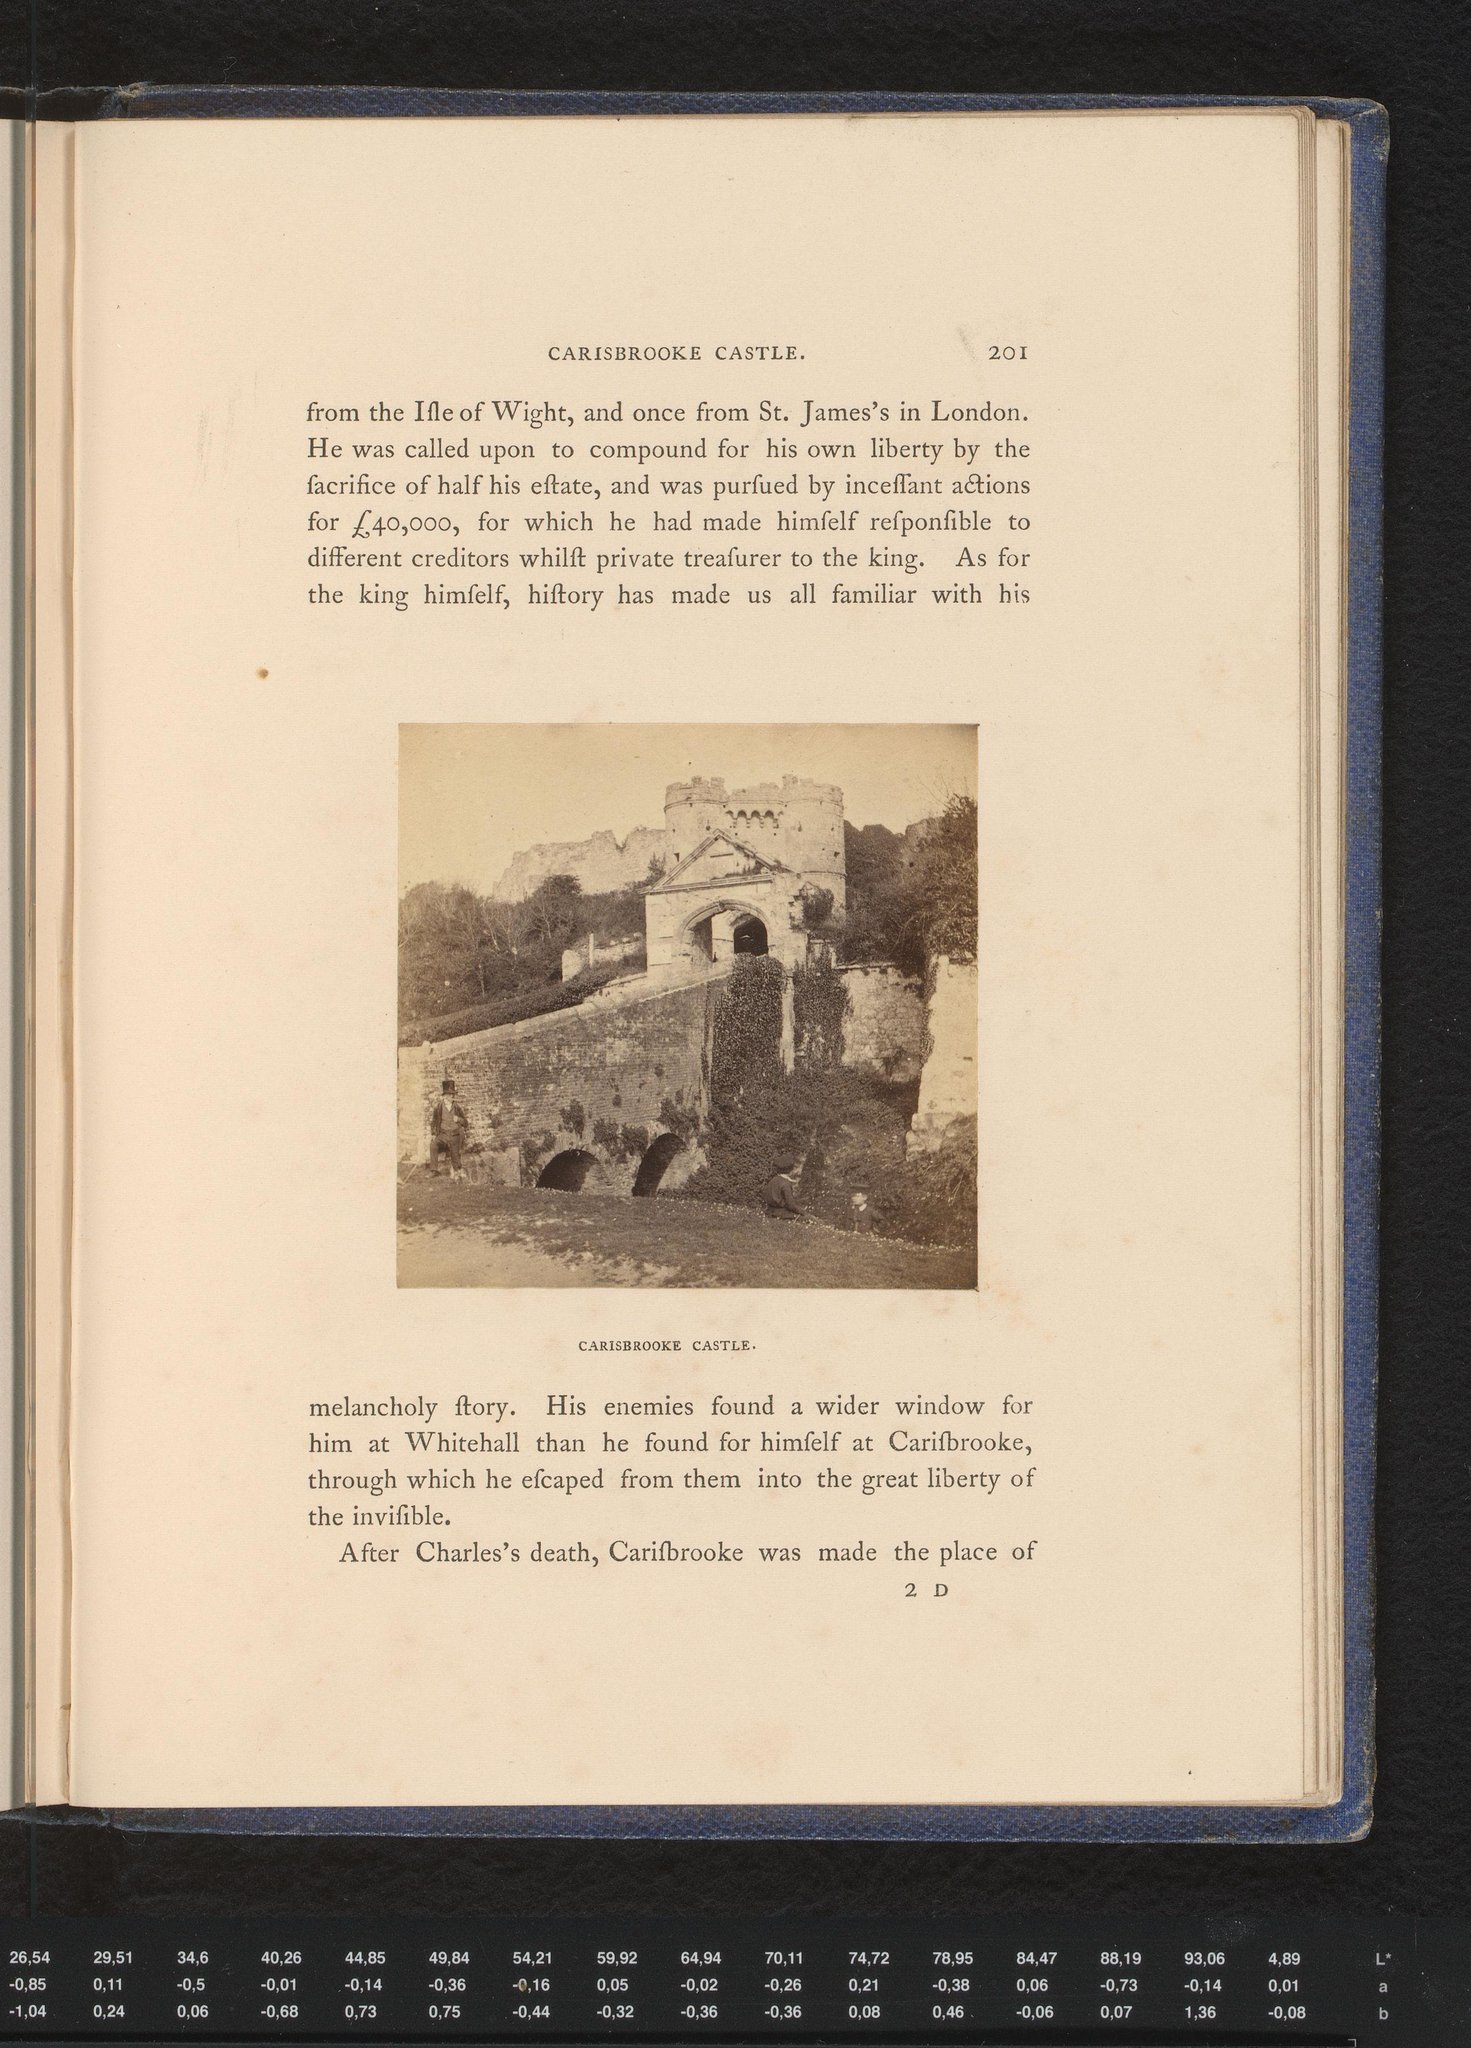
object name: page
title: Gezicht op Carisbrooke Castle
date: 1857-1862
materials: paper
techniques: albumen print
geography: carisbrooke castle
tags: landscape with ruins (+ city(-scape) with figures, staffage), ruin of a dwelling, house, castle, etc.